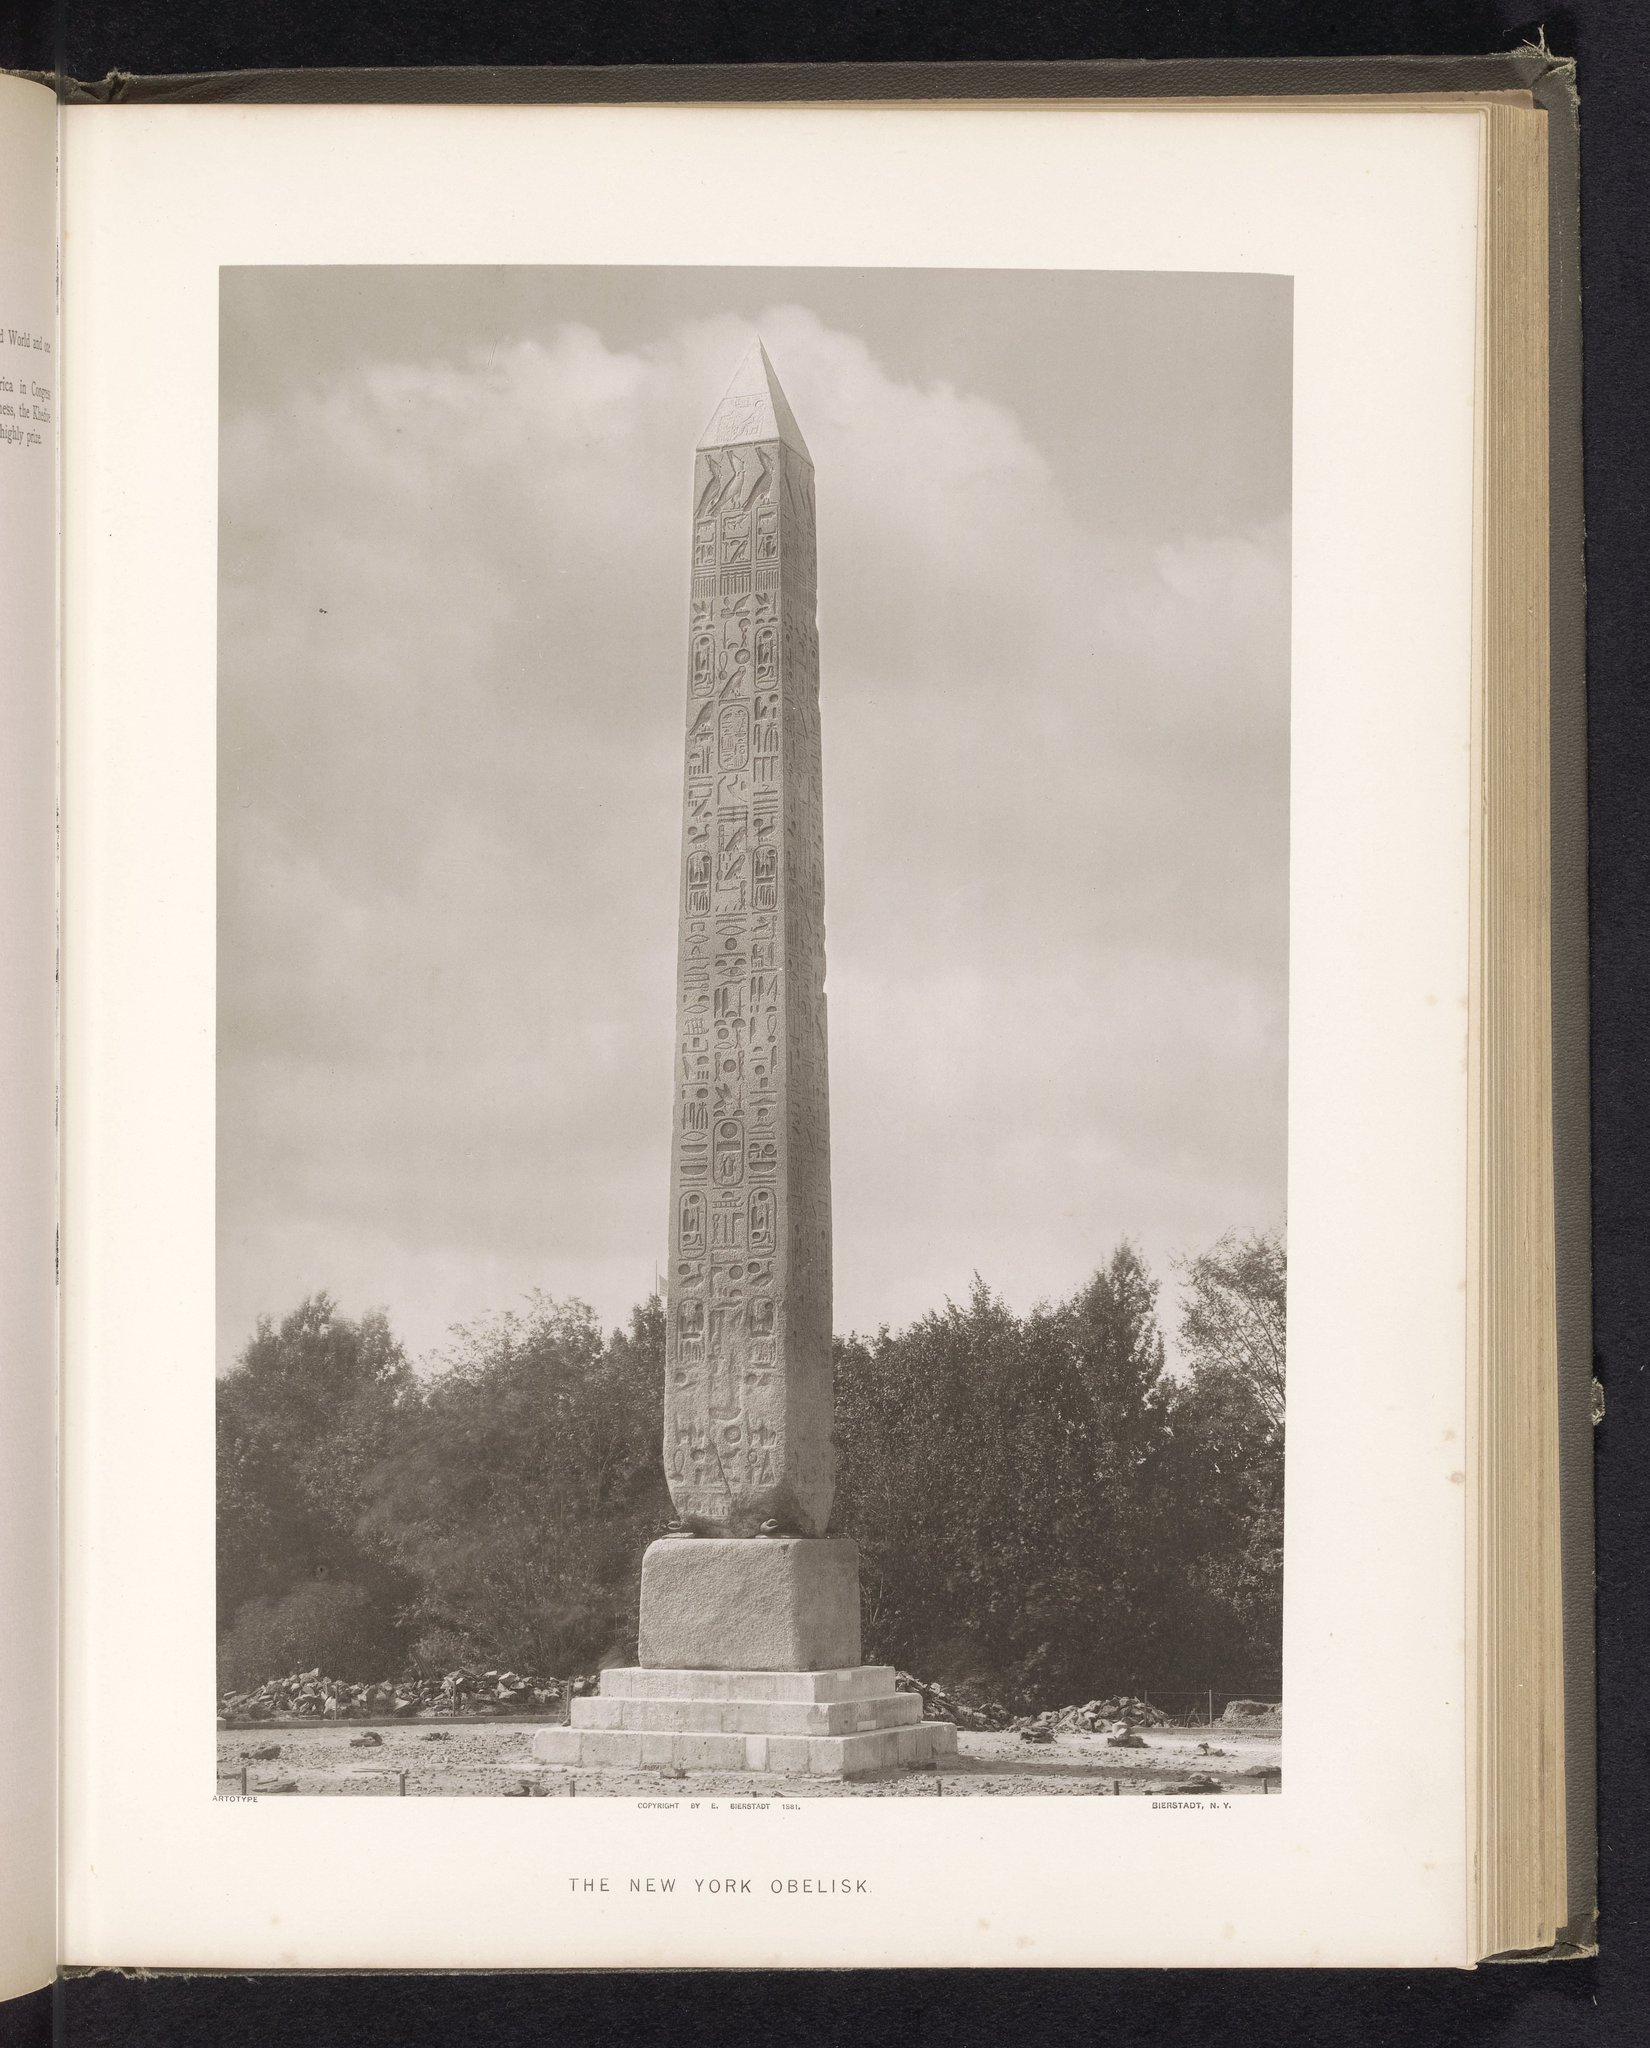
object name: photomechanical print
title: The New York obelisk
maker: Anonymous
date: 1881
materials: paper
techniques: photograph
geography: new york city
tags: obelisk, needle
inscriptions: inscription: ‘Copyright by E. Bierstadt 1981.’